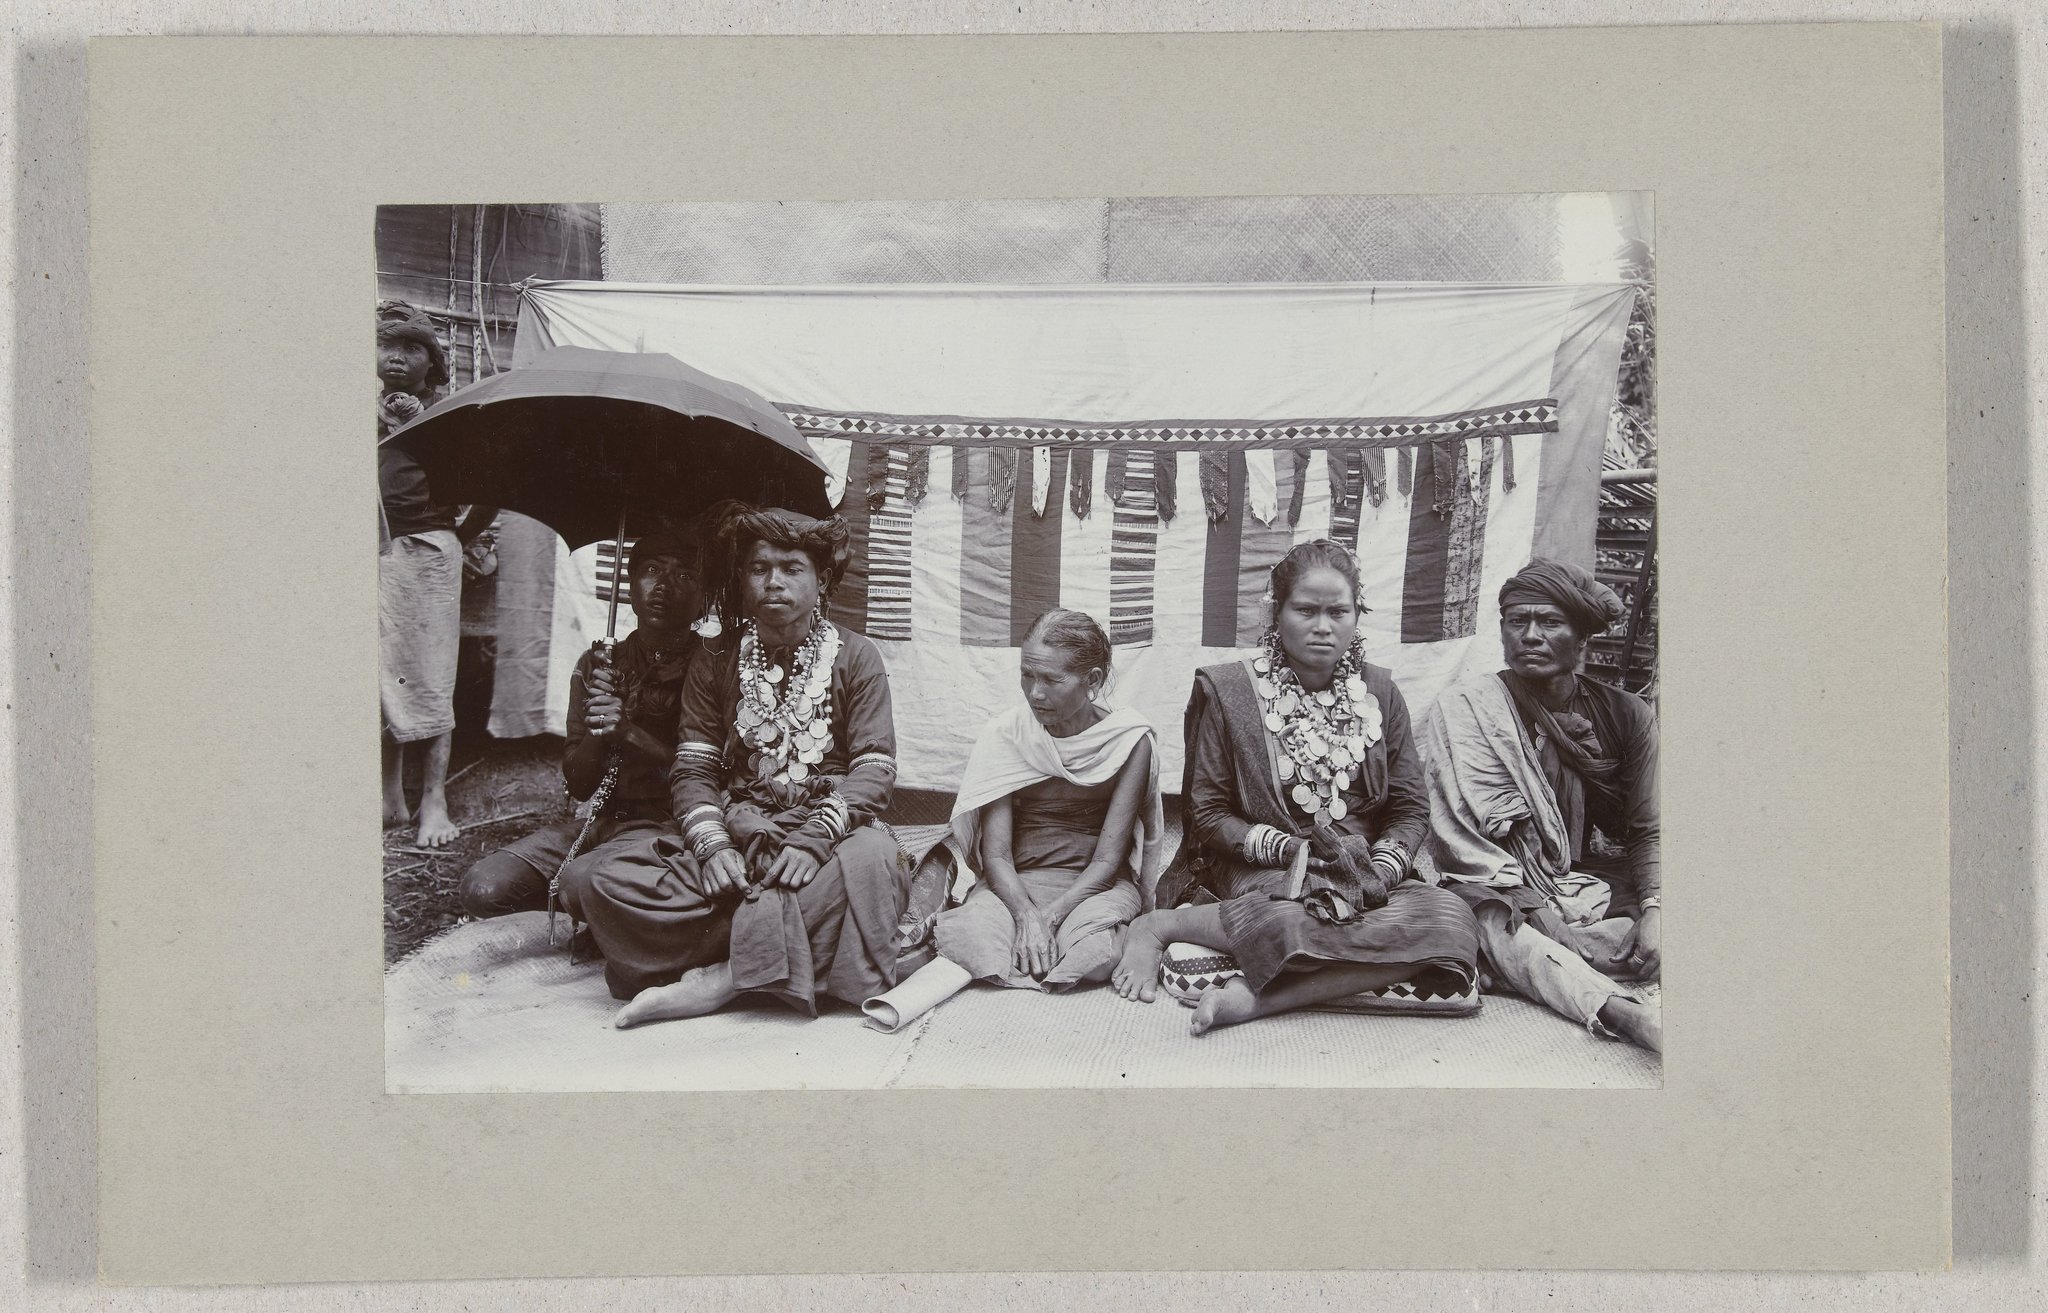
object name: photograph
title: Traditioneel bruidspaar op Sumatra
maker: Anonymous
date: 1895-1915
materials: cardboard, paper, photographic support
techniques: gelatin silver print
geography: sumatra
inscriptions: number: ‘10b’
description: Bruidspaar zittend op een rieten mat, Sumatra (?), Nederlands-Indië. Naast het bruidspaar een man, een vrouw en een man met een parasol